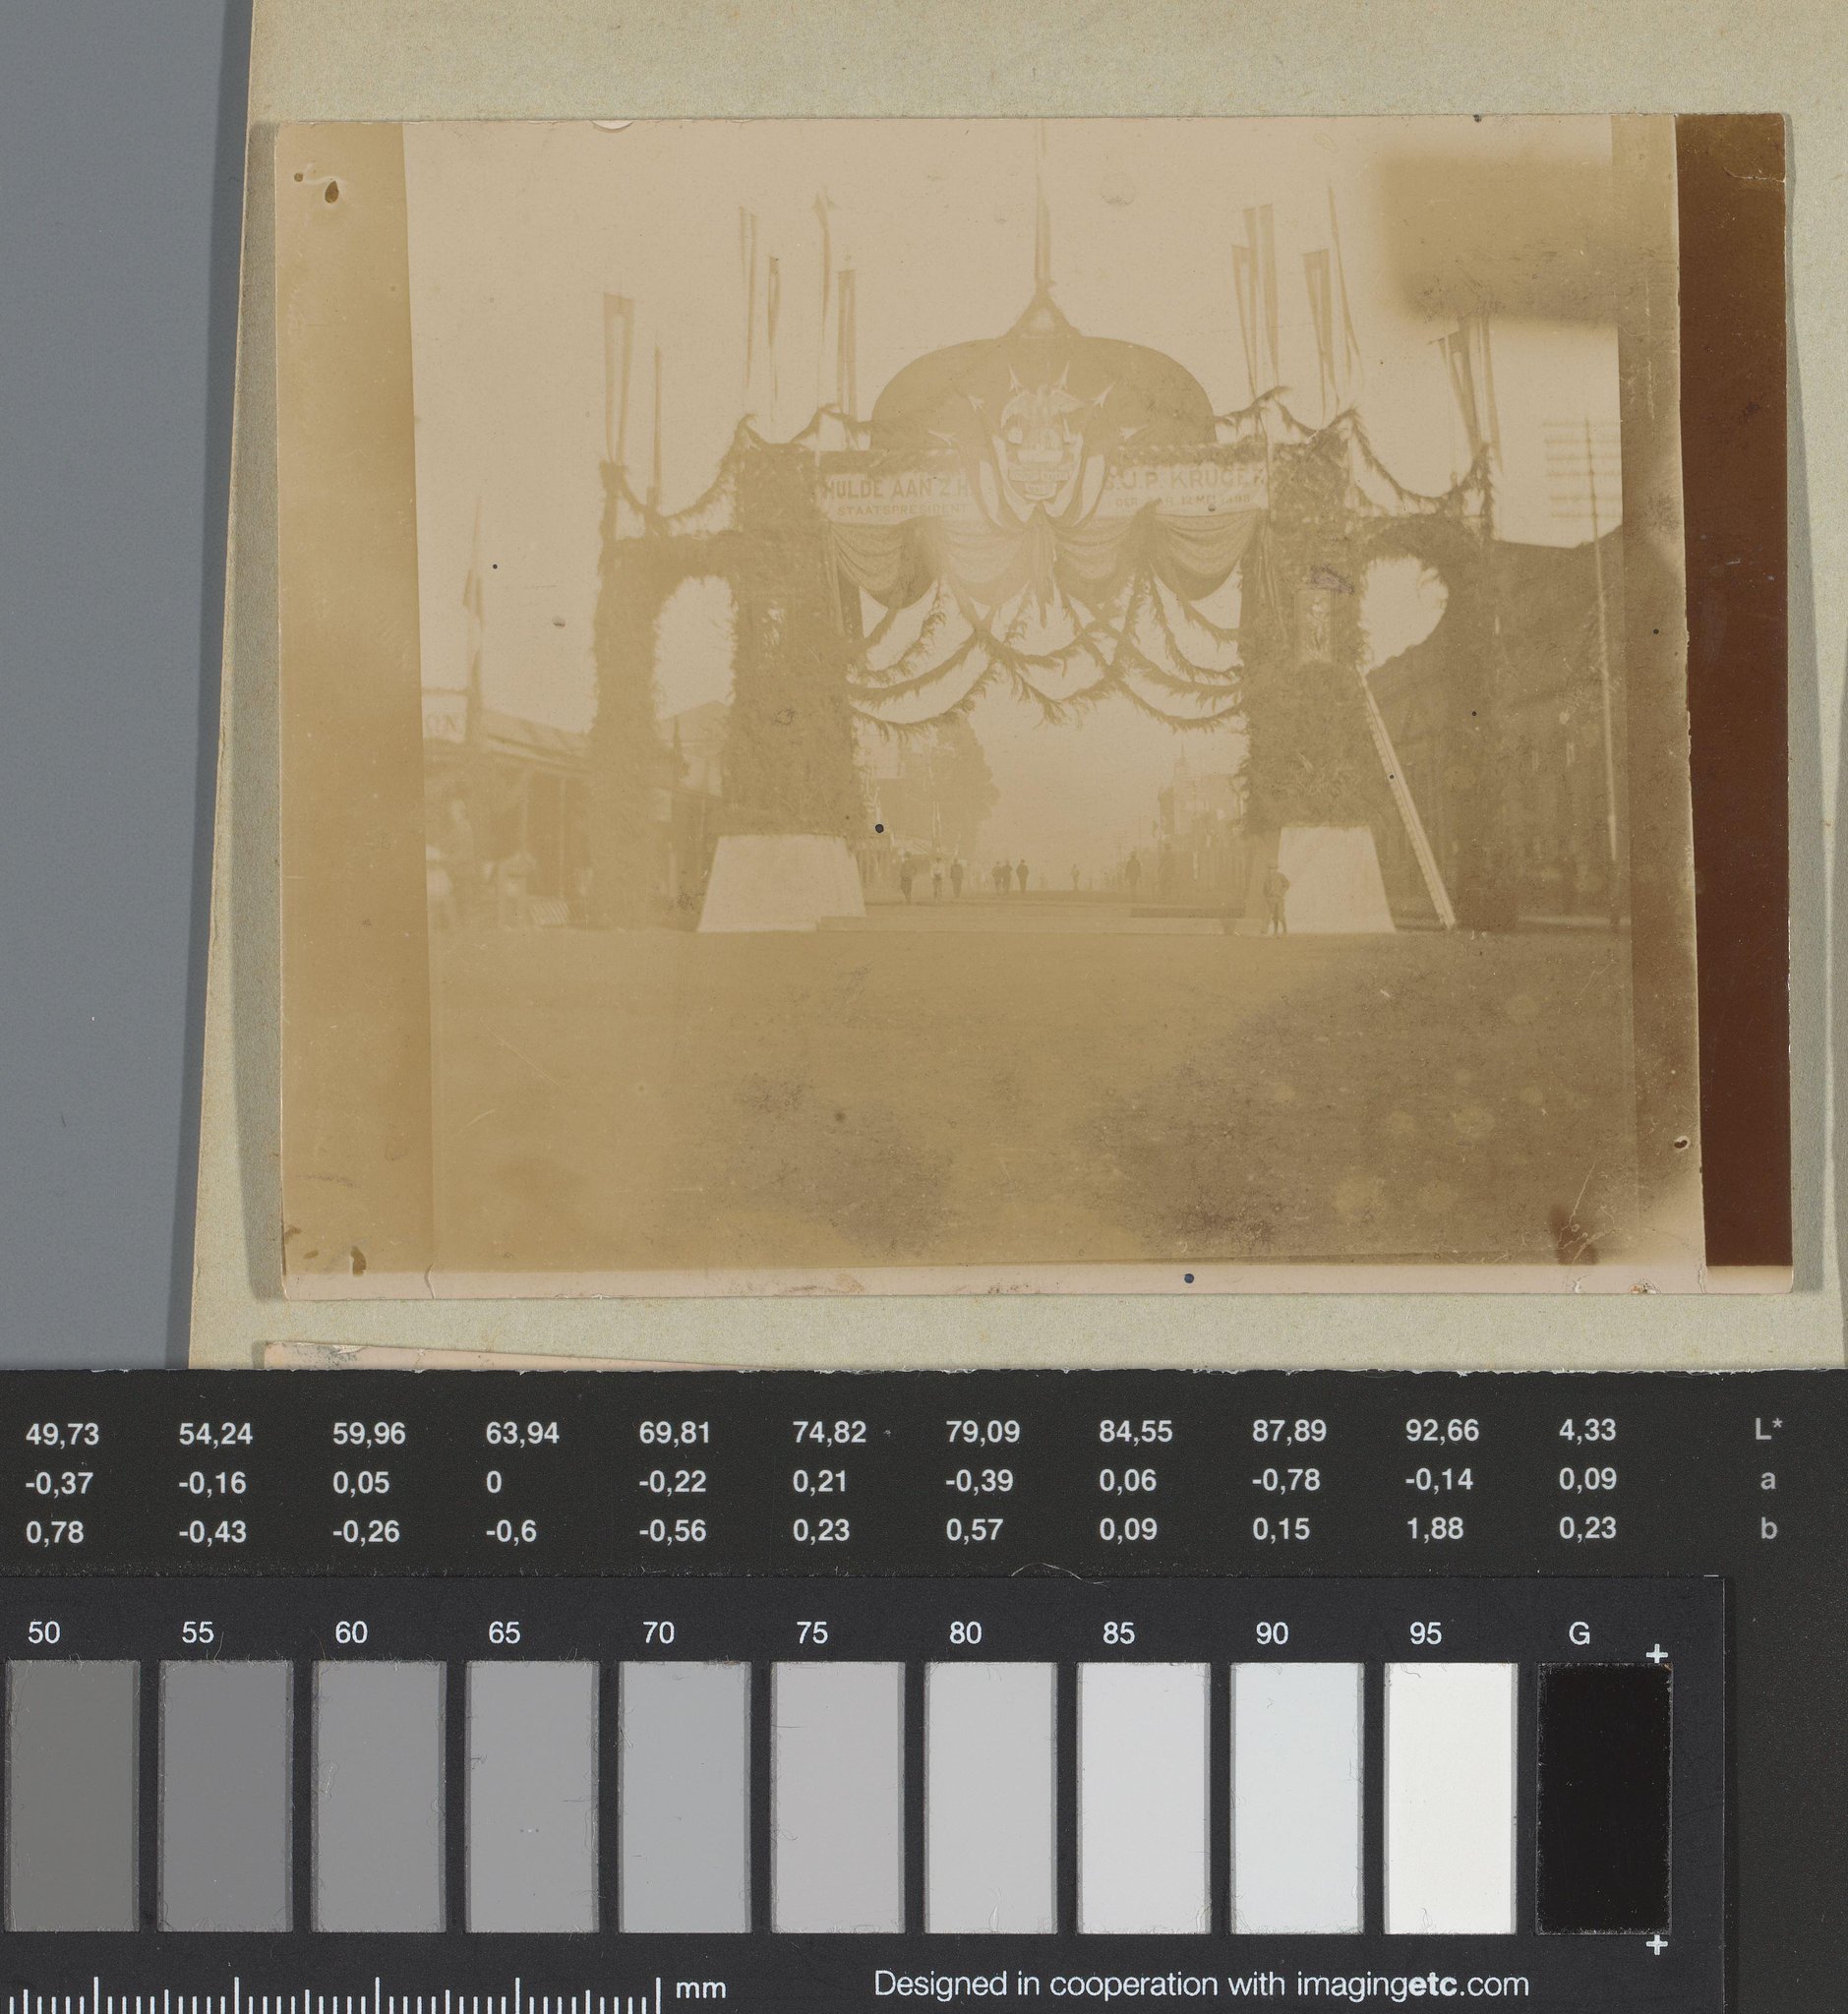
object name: photograph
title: Ereboog ter ere van de inhuldiging van president Kruger in Pretoria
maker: Anonymous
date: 1898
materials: paper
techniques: gelatin silver print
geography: pretoria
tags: ceremonial celebration of installation of a ruler, triumphal arch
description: Op 12 mei 1898 werd president S.J.P. Kruger ingehuldigd voor zijn vierde ambtstermijn als president.